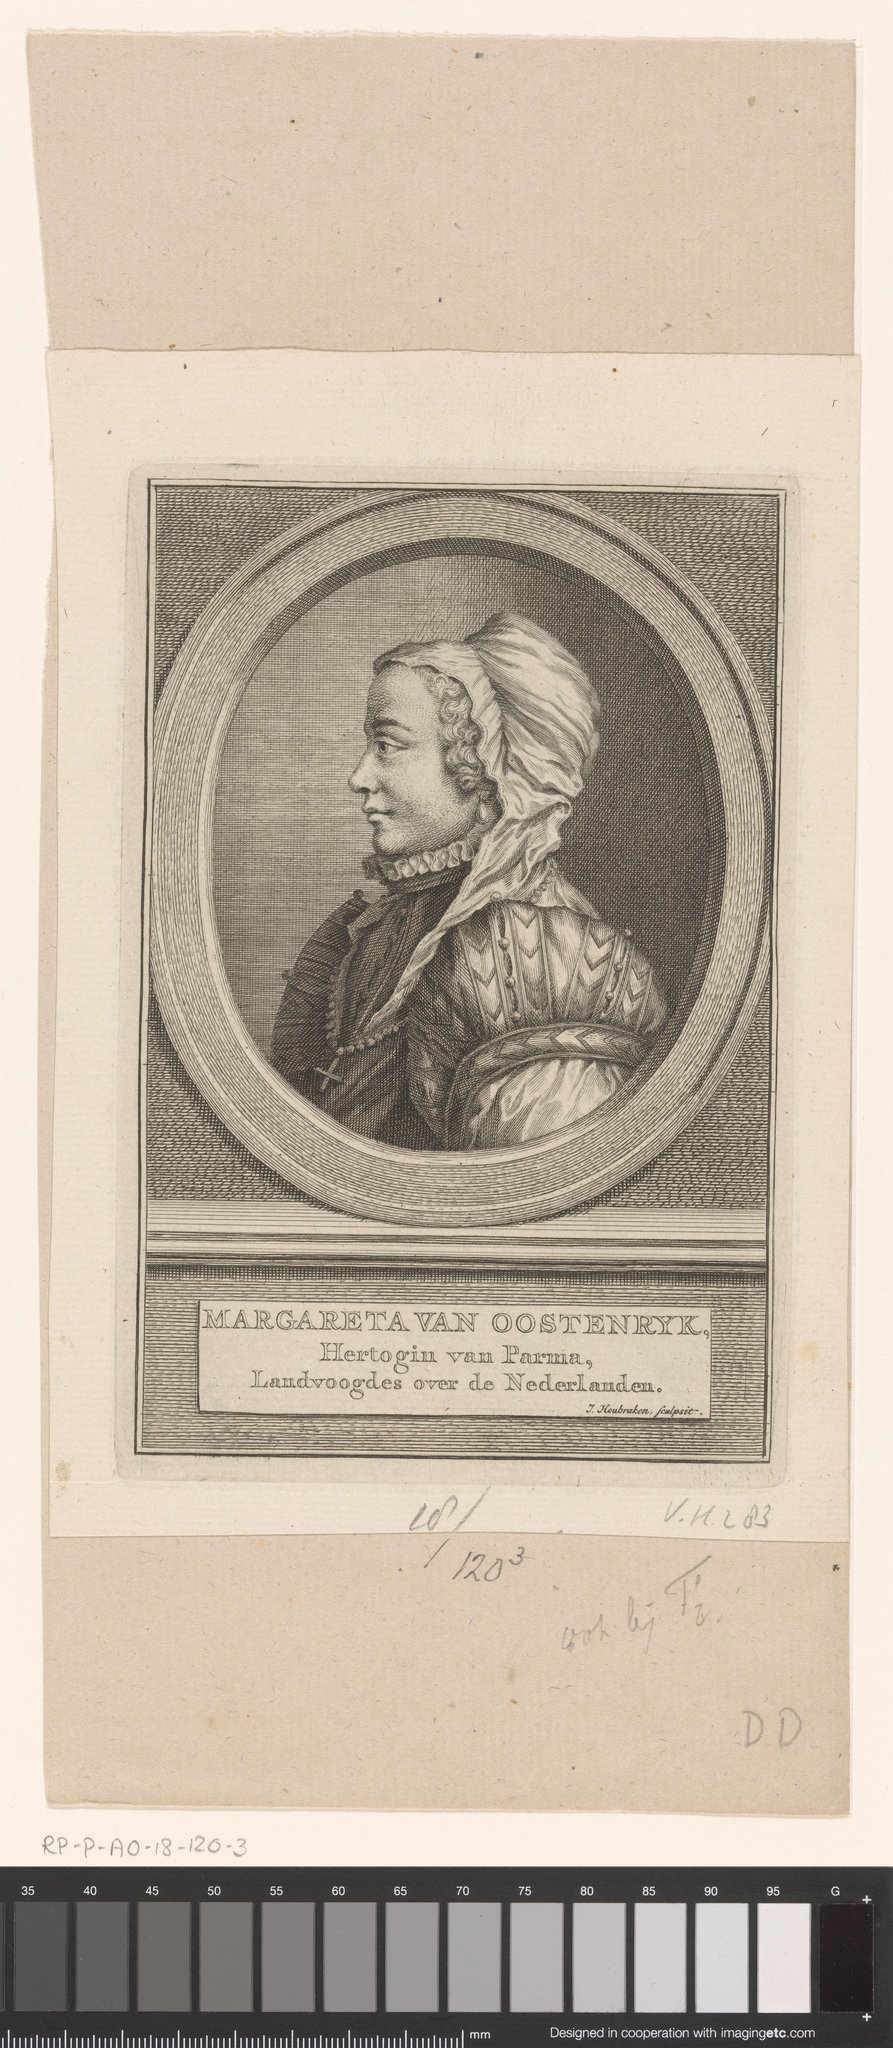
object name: print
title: Margareta van Oostenrijk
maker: jacob houbraken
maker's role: draughtsman, print maker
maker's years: 1698-1780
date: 1749-1780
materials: paper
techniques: engraving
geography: amsterdam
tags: historical persons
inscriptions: collector's mark: Lugt 2228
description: Deze prent is oorspronkelijk bedoeld als aanvulling op Jan Wagenaars ‘Vaderlandsche historie’* en was zo vanaf 1796 verkrijgbaar bij Johannes Allart te Amsterdam. Voor de advertentie waarin Allart de 60 portretten en 7 platen, allen gegraveerd door Houbraken, ter aanvulling op Wagenaars ‘Vaderlandsche historie’ aanbiedt, zie RP-P-OB-77.766. *Van dit werk zijn in de achttiende eeuw meerdere uitgaves verschenen, zoals: Wagenaar, Jan. Vaderlandsche historie, vervattende de geschiedenissen der Vereenigde Nederlanden (…). 21 delen. Amsterdam: Isaak Tirion, 1749-1759. Wagenaar, Jan. Vaderlandsche historie, vervattende de geschiedenissen der nu Vereenigde Nederlanden (…). 21 delen. Amsterdam: weduwe Isaak Tirion, 1770. Wagenaar, Jan. Vaderlandsche historie, vervattende de geschiedenissen der nu Vereenigde Nederlanden (…). 21 delen. Amsterdam, Leiden, Dordrecht en Harlingen: P. Schouten e.a., 1782. Wagenaar, Jan. Vaderlandsche historie, vervattende de geschiedenissen der nu Vereenigde Nederlanden (…). 21 delen. Amsterdam: Johannes Allart, 1790-1796.